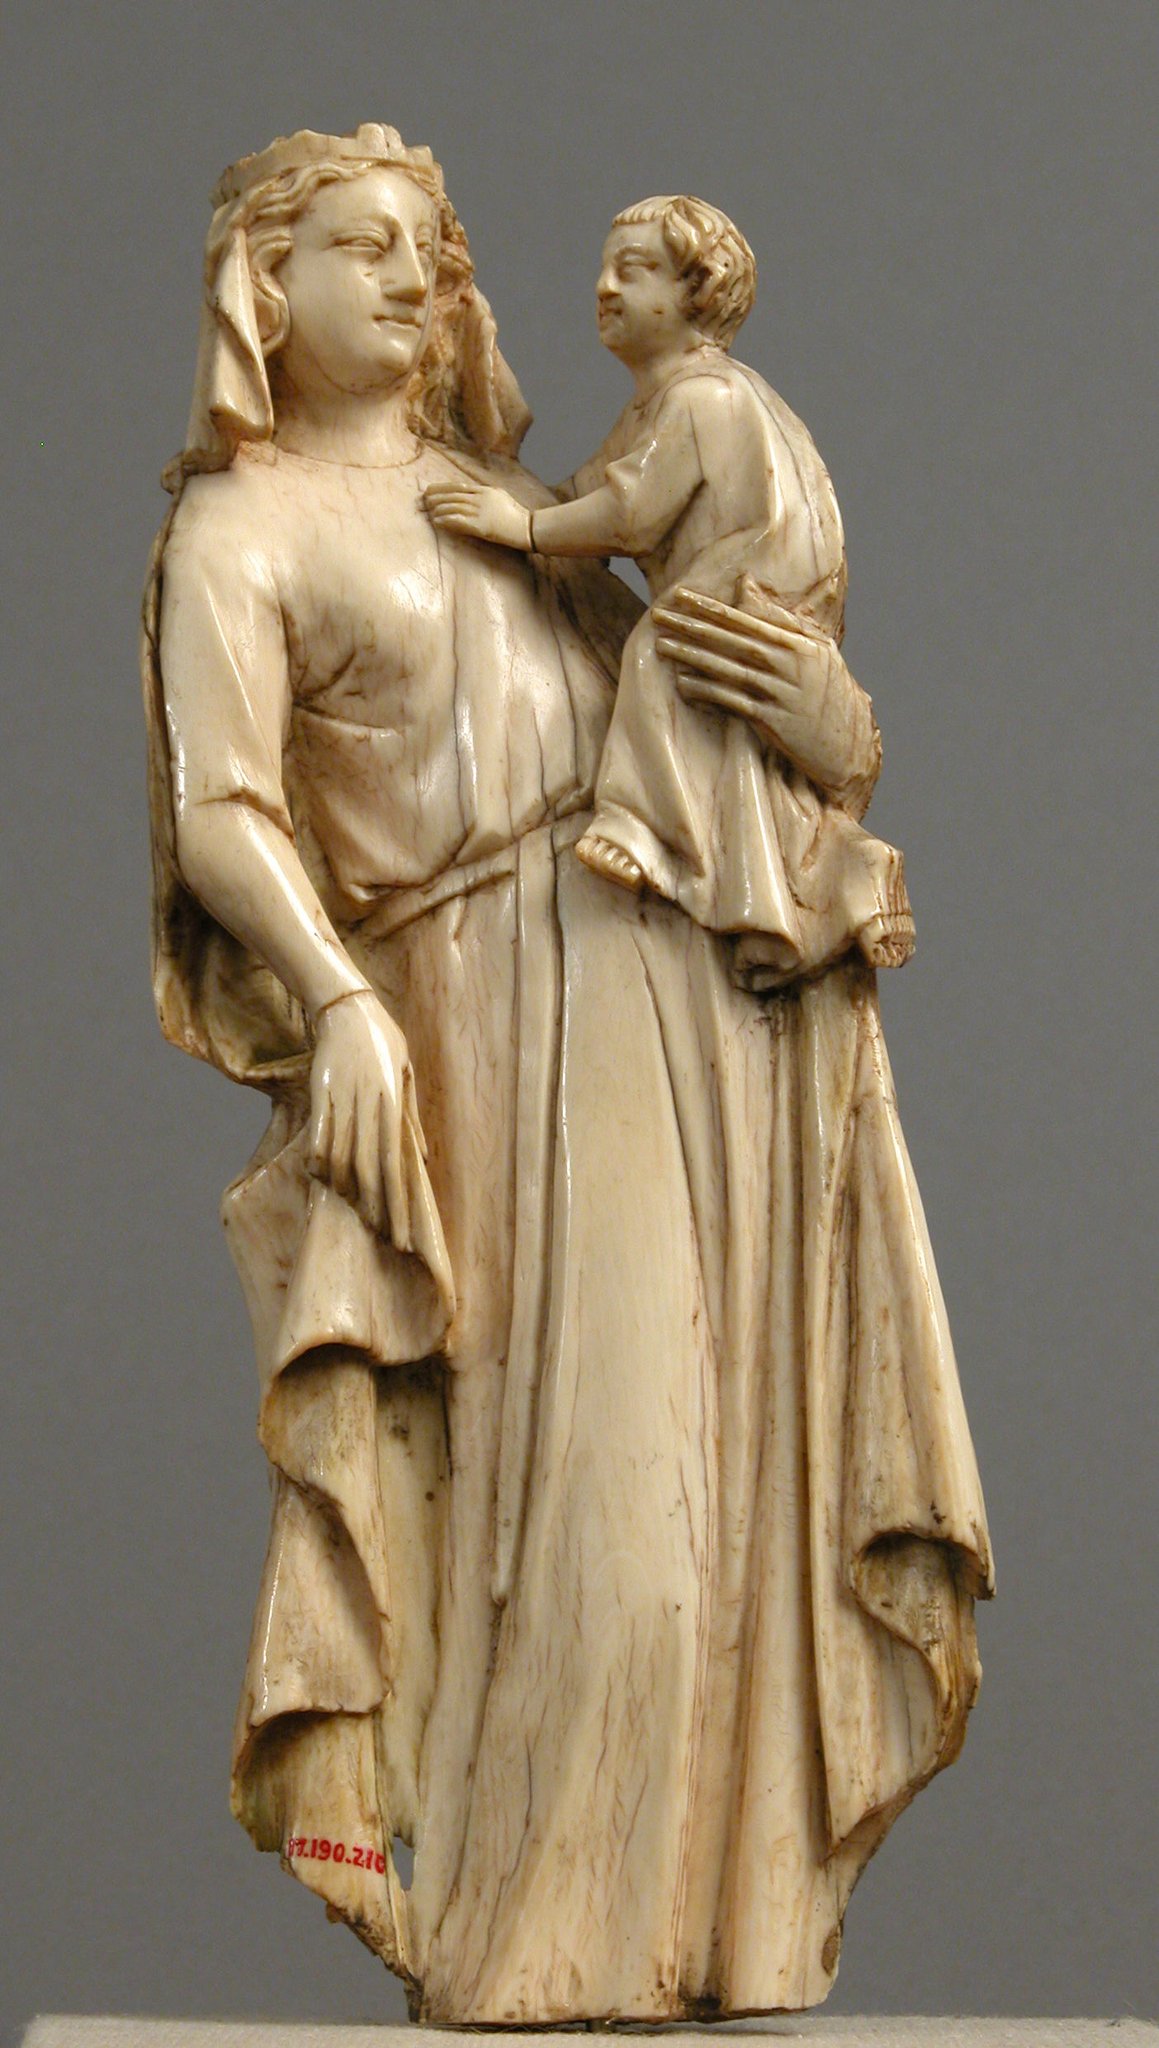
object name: relief statue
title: Virgin and Child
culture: french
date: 1334-1366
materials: ivory